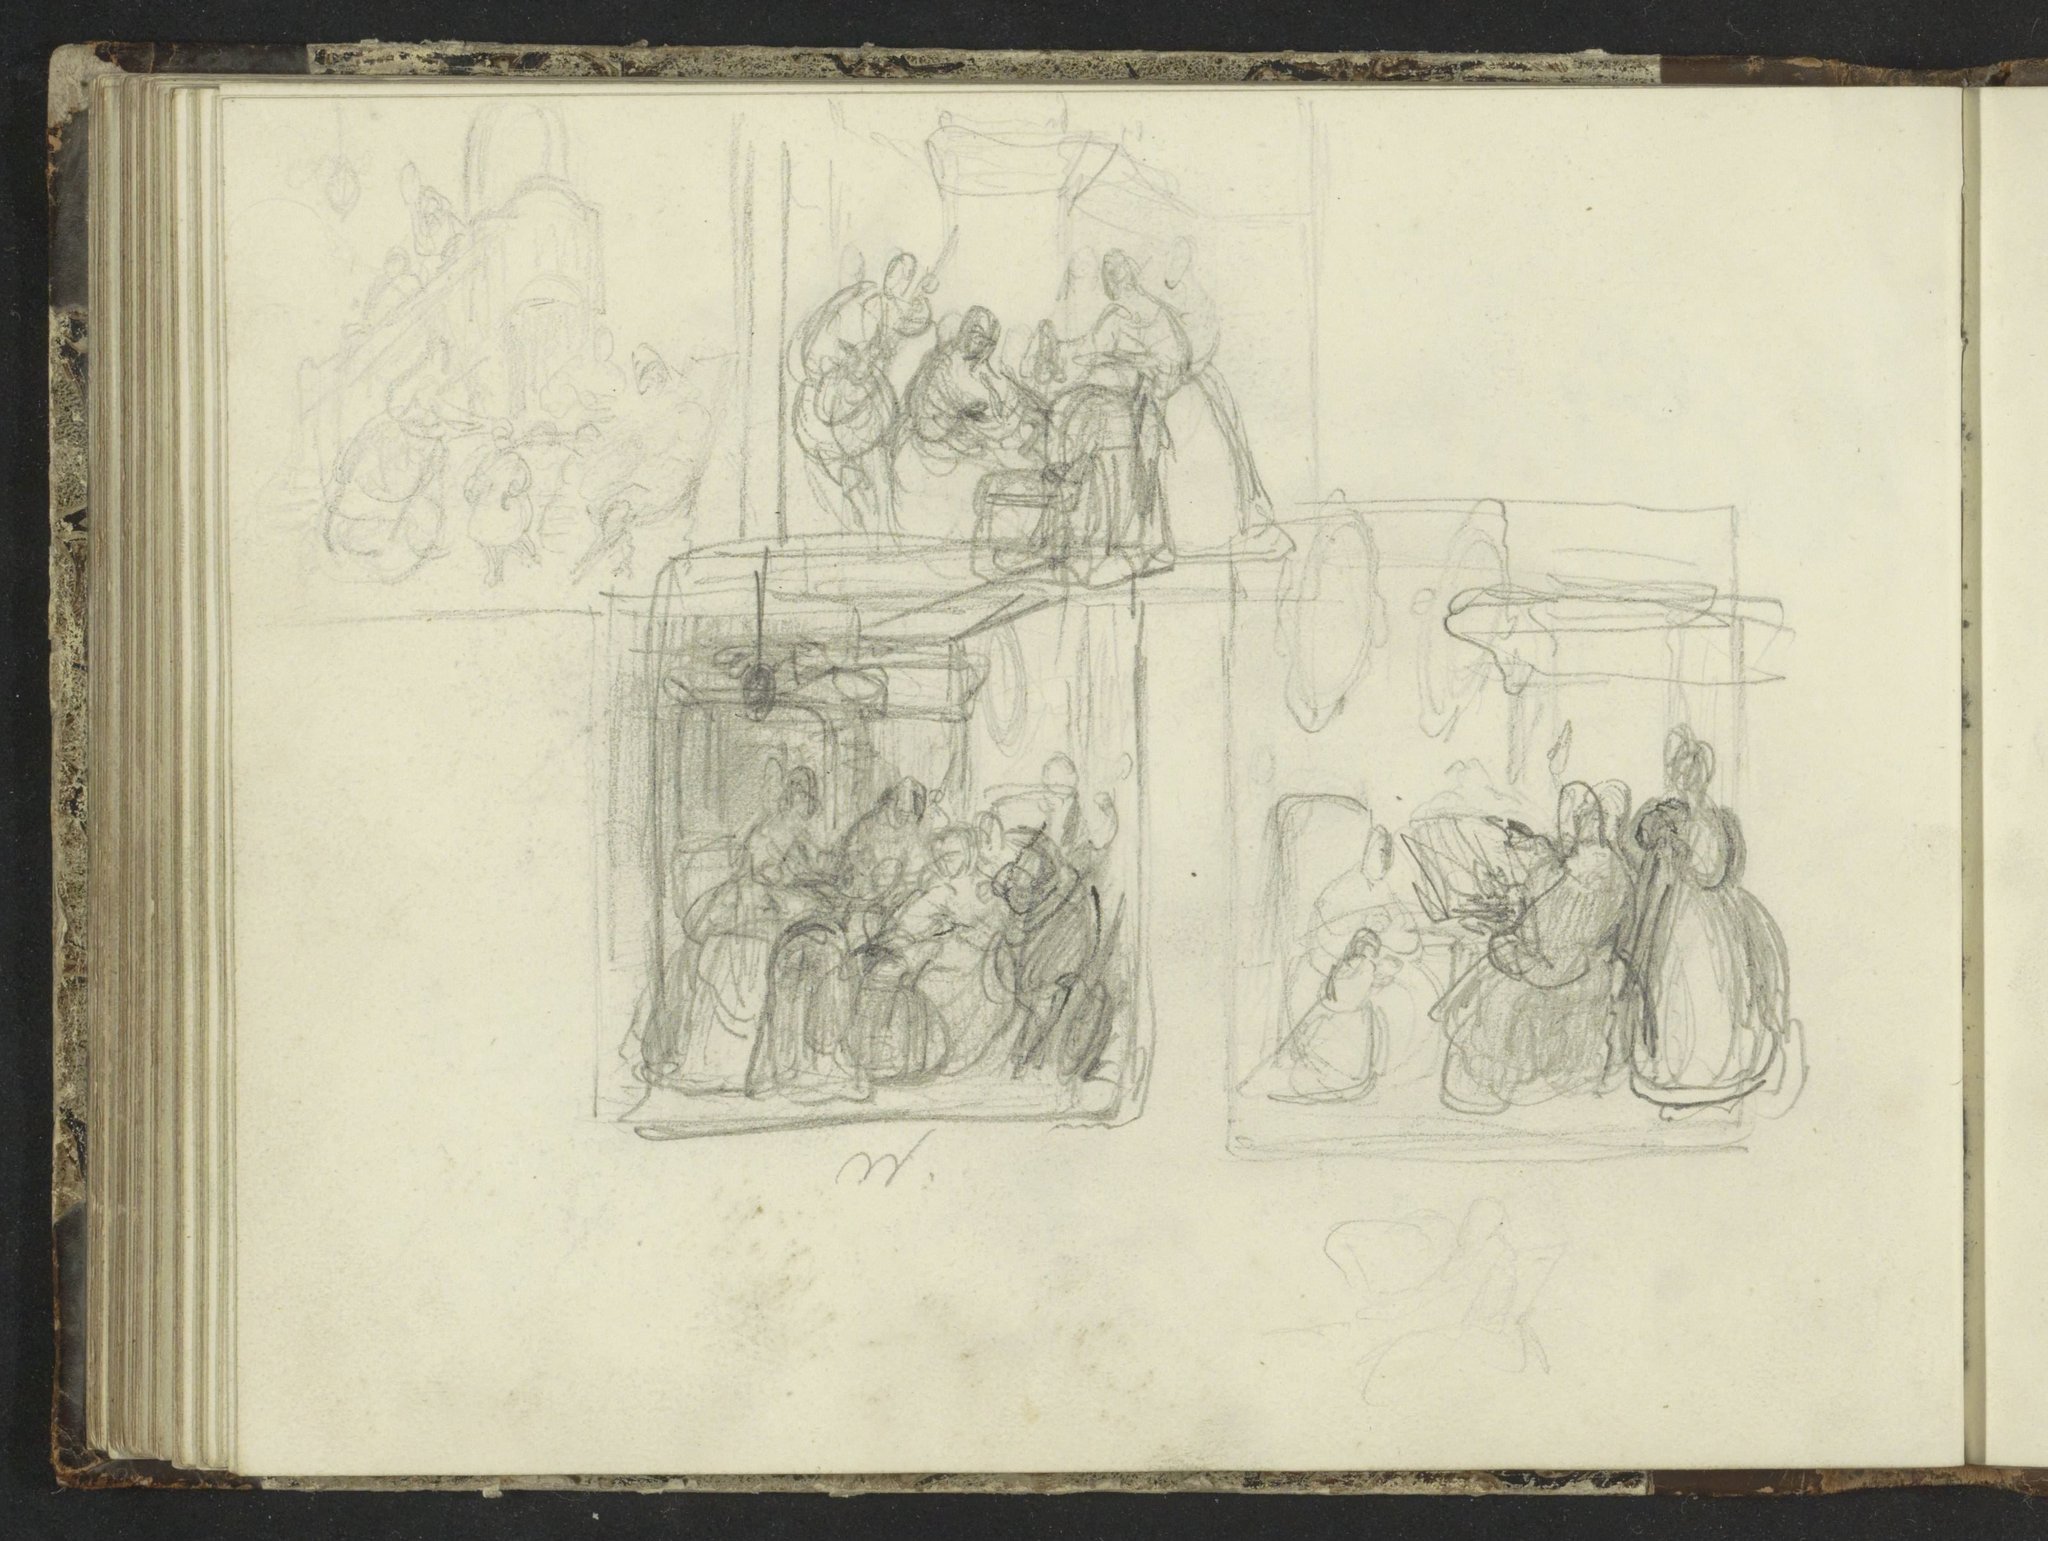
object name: sketchbook leaf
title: Compositiestudies met figuren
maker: willem hendrik schmidt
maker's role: draughtsman, painter, print maker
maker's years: 1809-1849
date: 1819-1849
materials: paper, pencil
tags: village street, interior of the house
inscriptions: annotation: ‘W.’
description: Vier tekeningen in kaders, voornamelijk van figuren in interieurs en op straat. Blad 47 verso uit een schetsboek met 58 bladen.